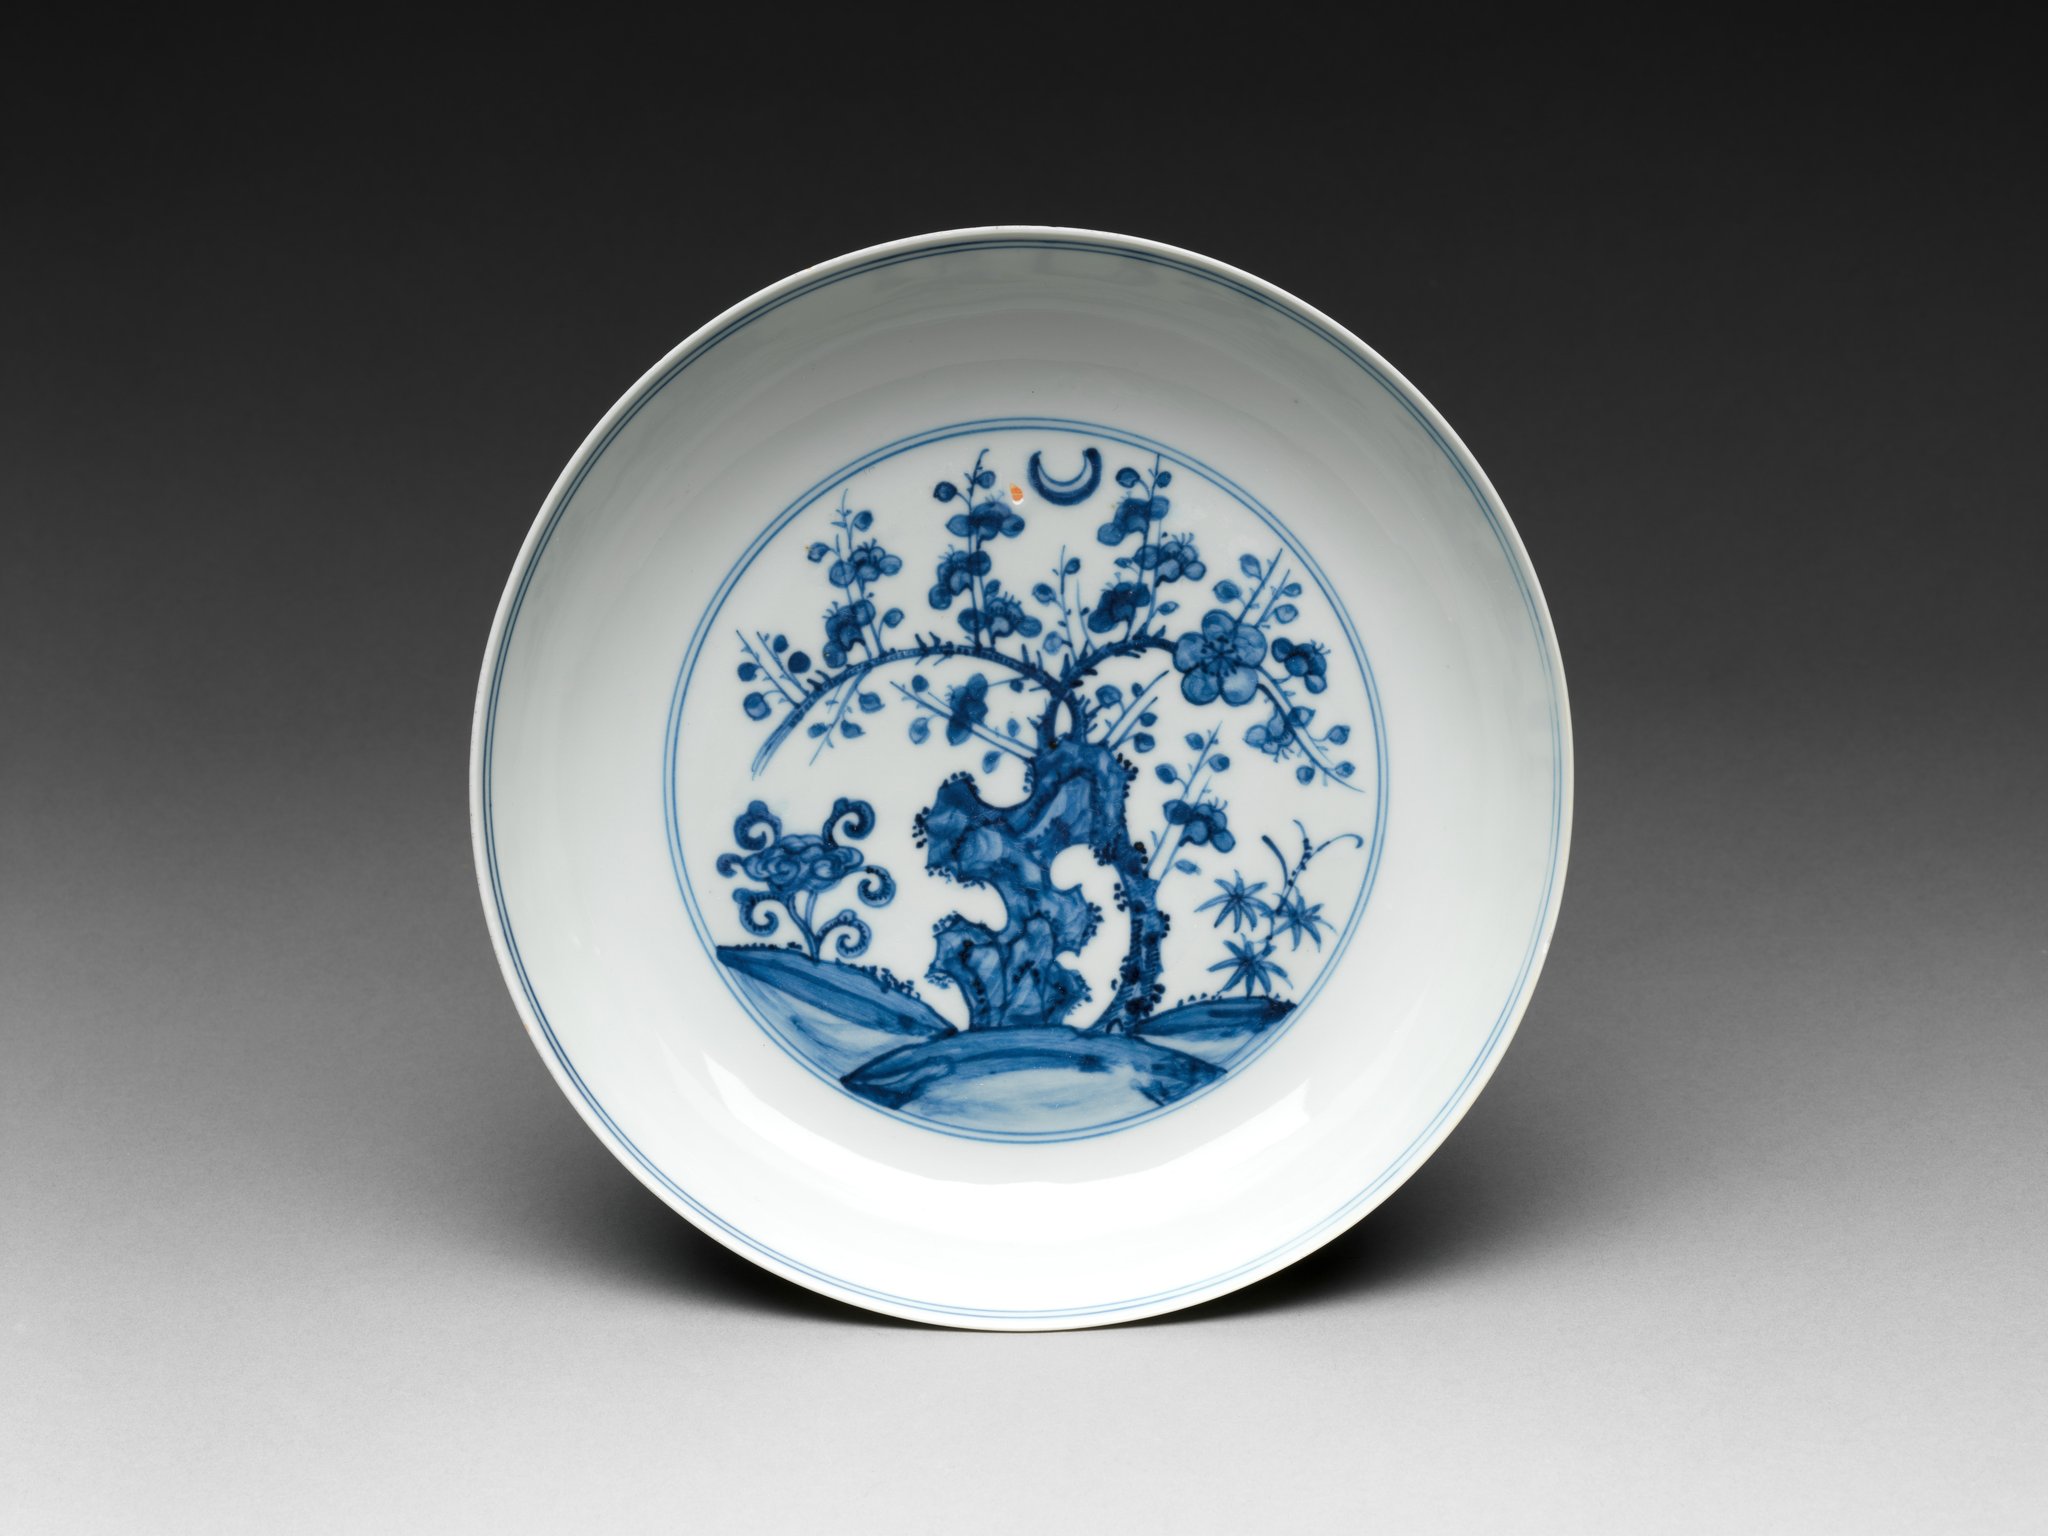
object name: dish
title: Dish with Blossoming Plum and Crescent Moon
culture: chinese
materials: cobalt, glaze, porcelain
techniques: painting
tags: moon,flowers,trees